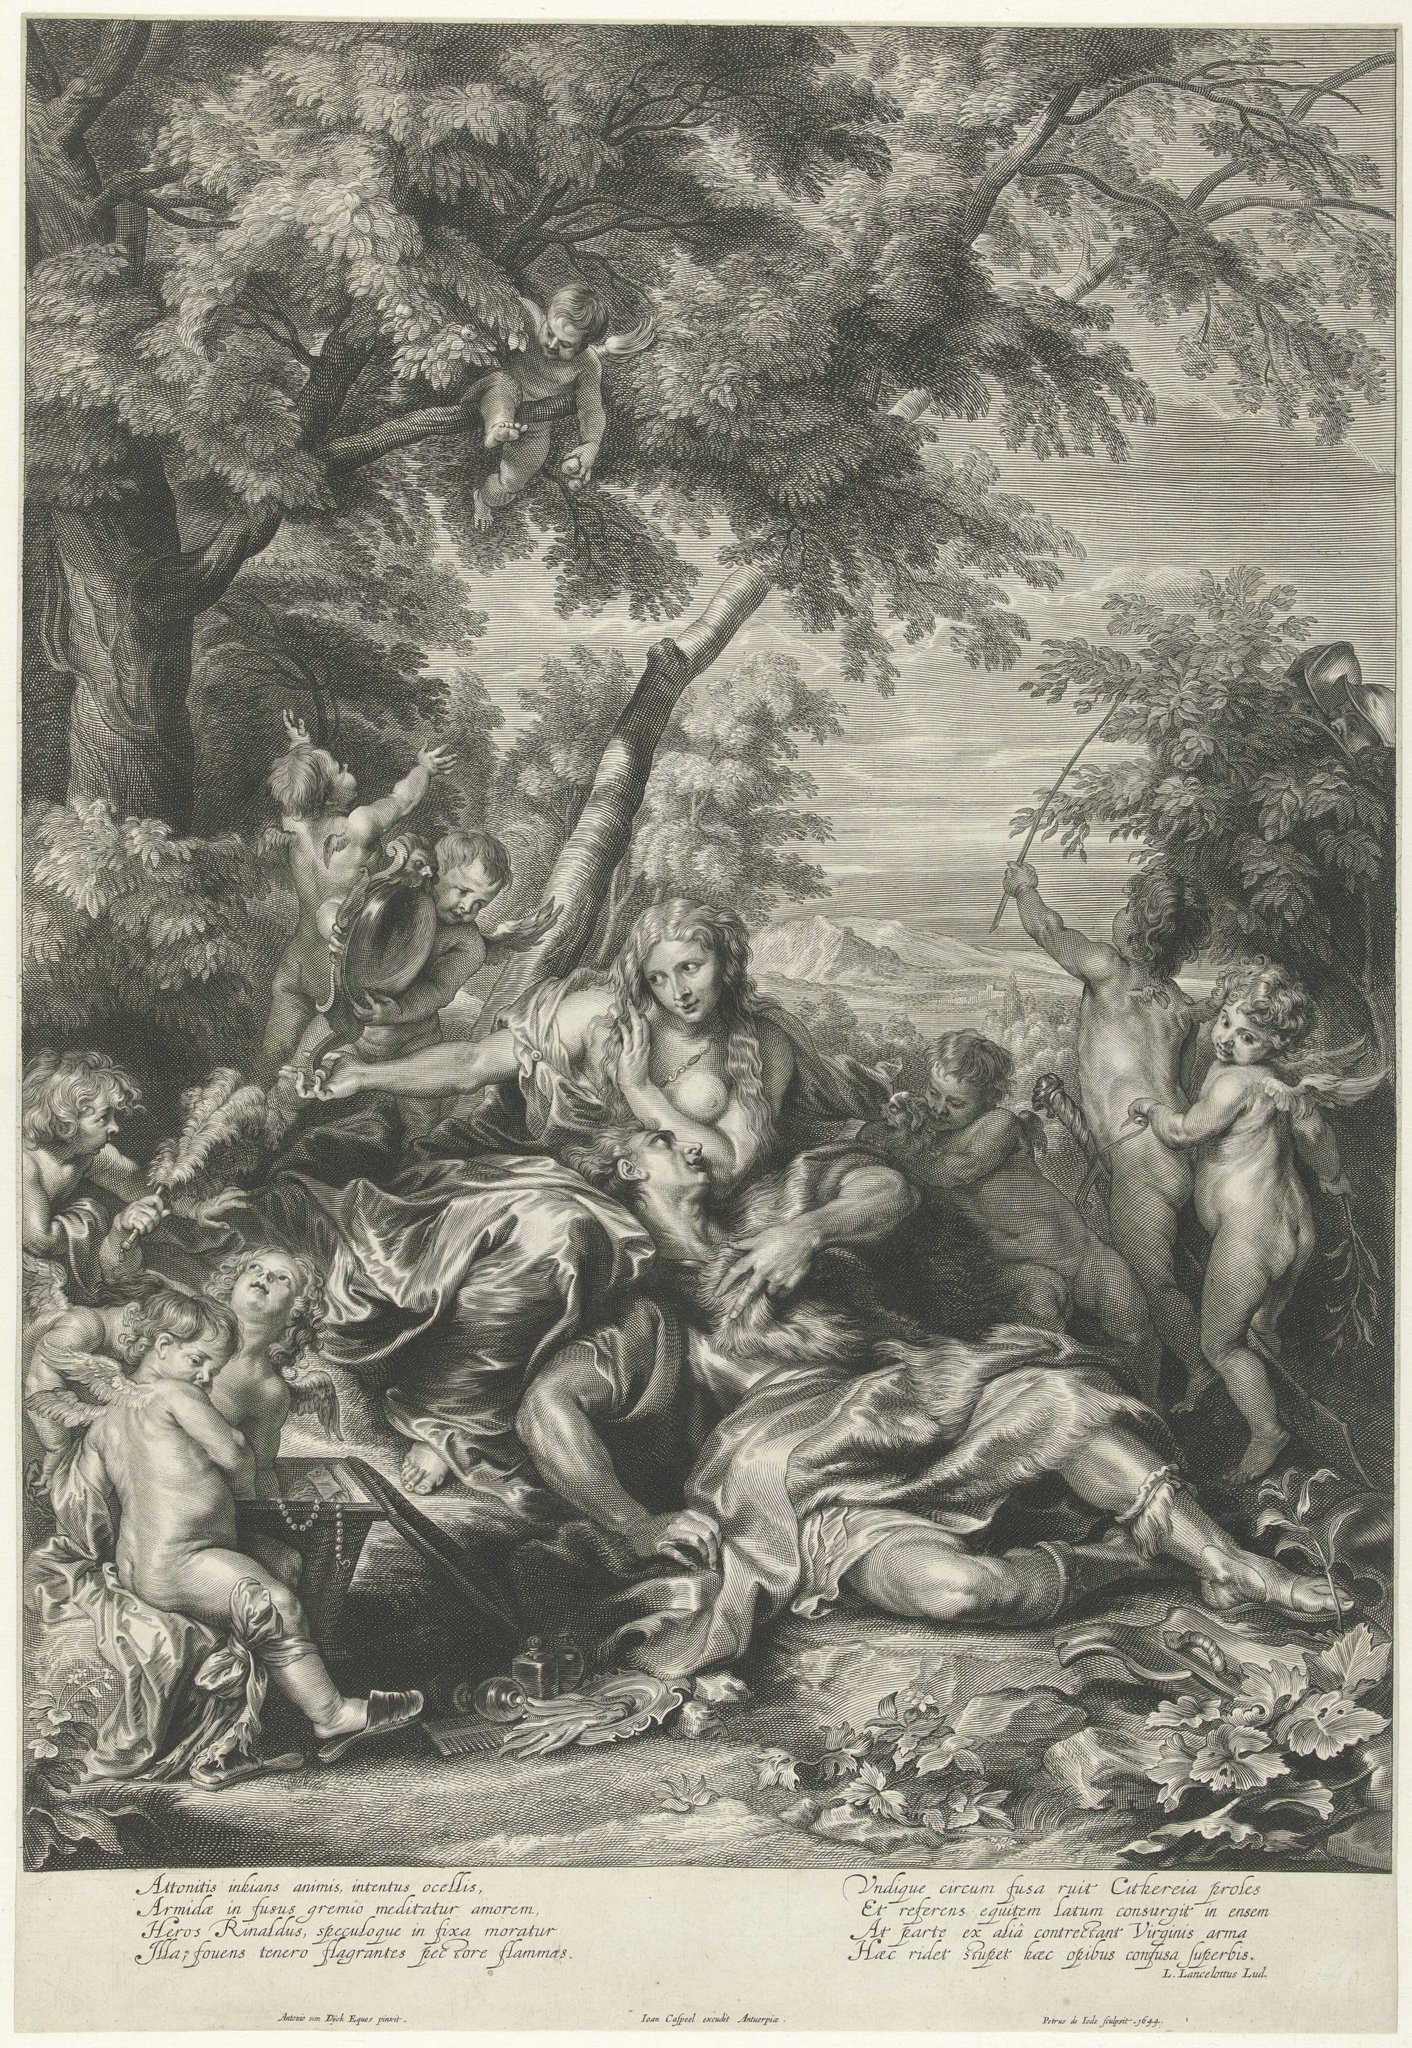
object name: print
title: Rinaldo en Armida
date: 1644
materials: paper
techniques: engraving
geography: antwerp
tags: rinaldo, armida, (scenes from) specific works of literature: tasso, gerusalemme liberata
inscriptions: collector's mark: Lugt 2228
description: Rinaldo rust in de schoot van de jonge Armida. Hij kijkt in haar ogen naar zijn eigen spiegelbeeld. Zij kijkt in een spiegel die door een putto omhoog gehouden wordt. Zo aanschouwen zij beiden hun eigen verliefde aanblik. De twee ridders die op zoek waren naar Rinaldo kijken toe vanuit de struiken. In de marge een achtregelig onderschrift, in twee kolommen, in het Latijn.